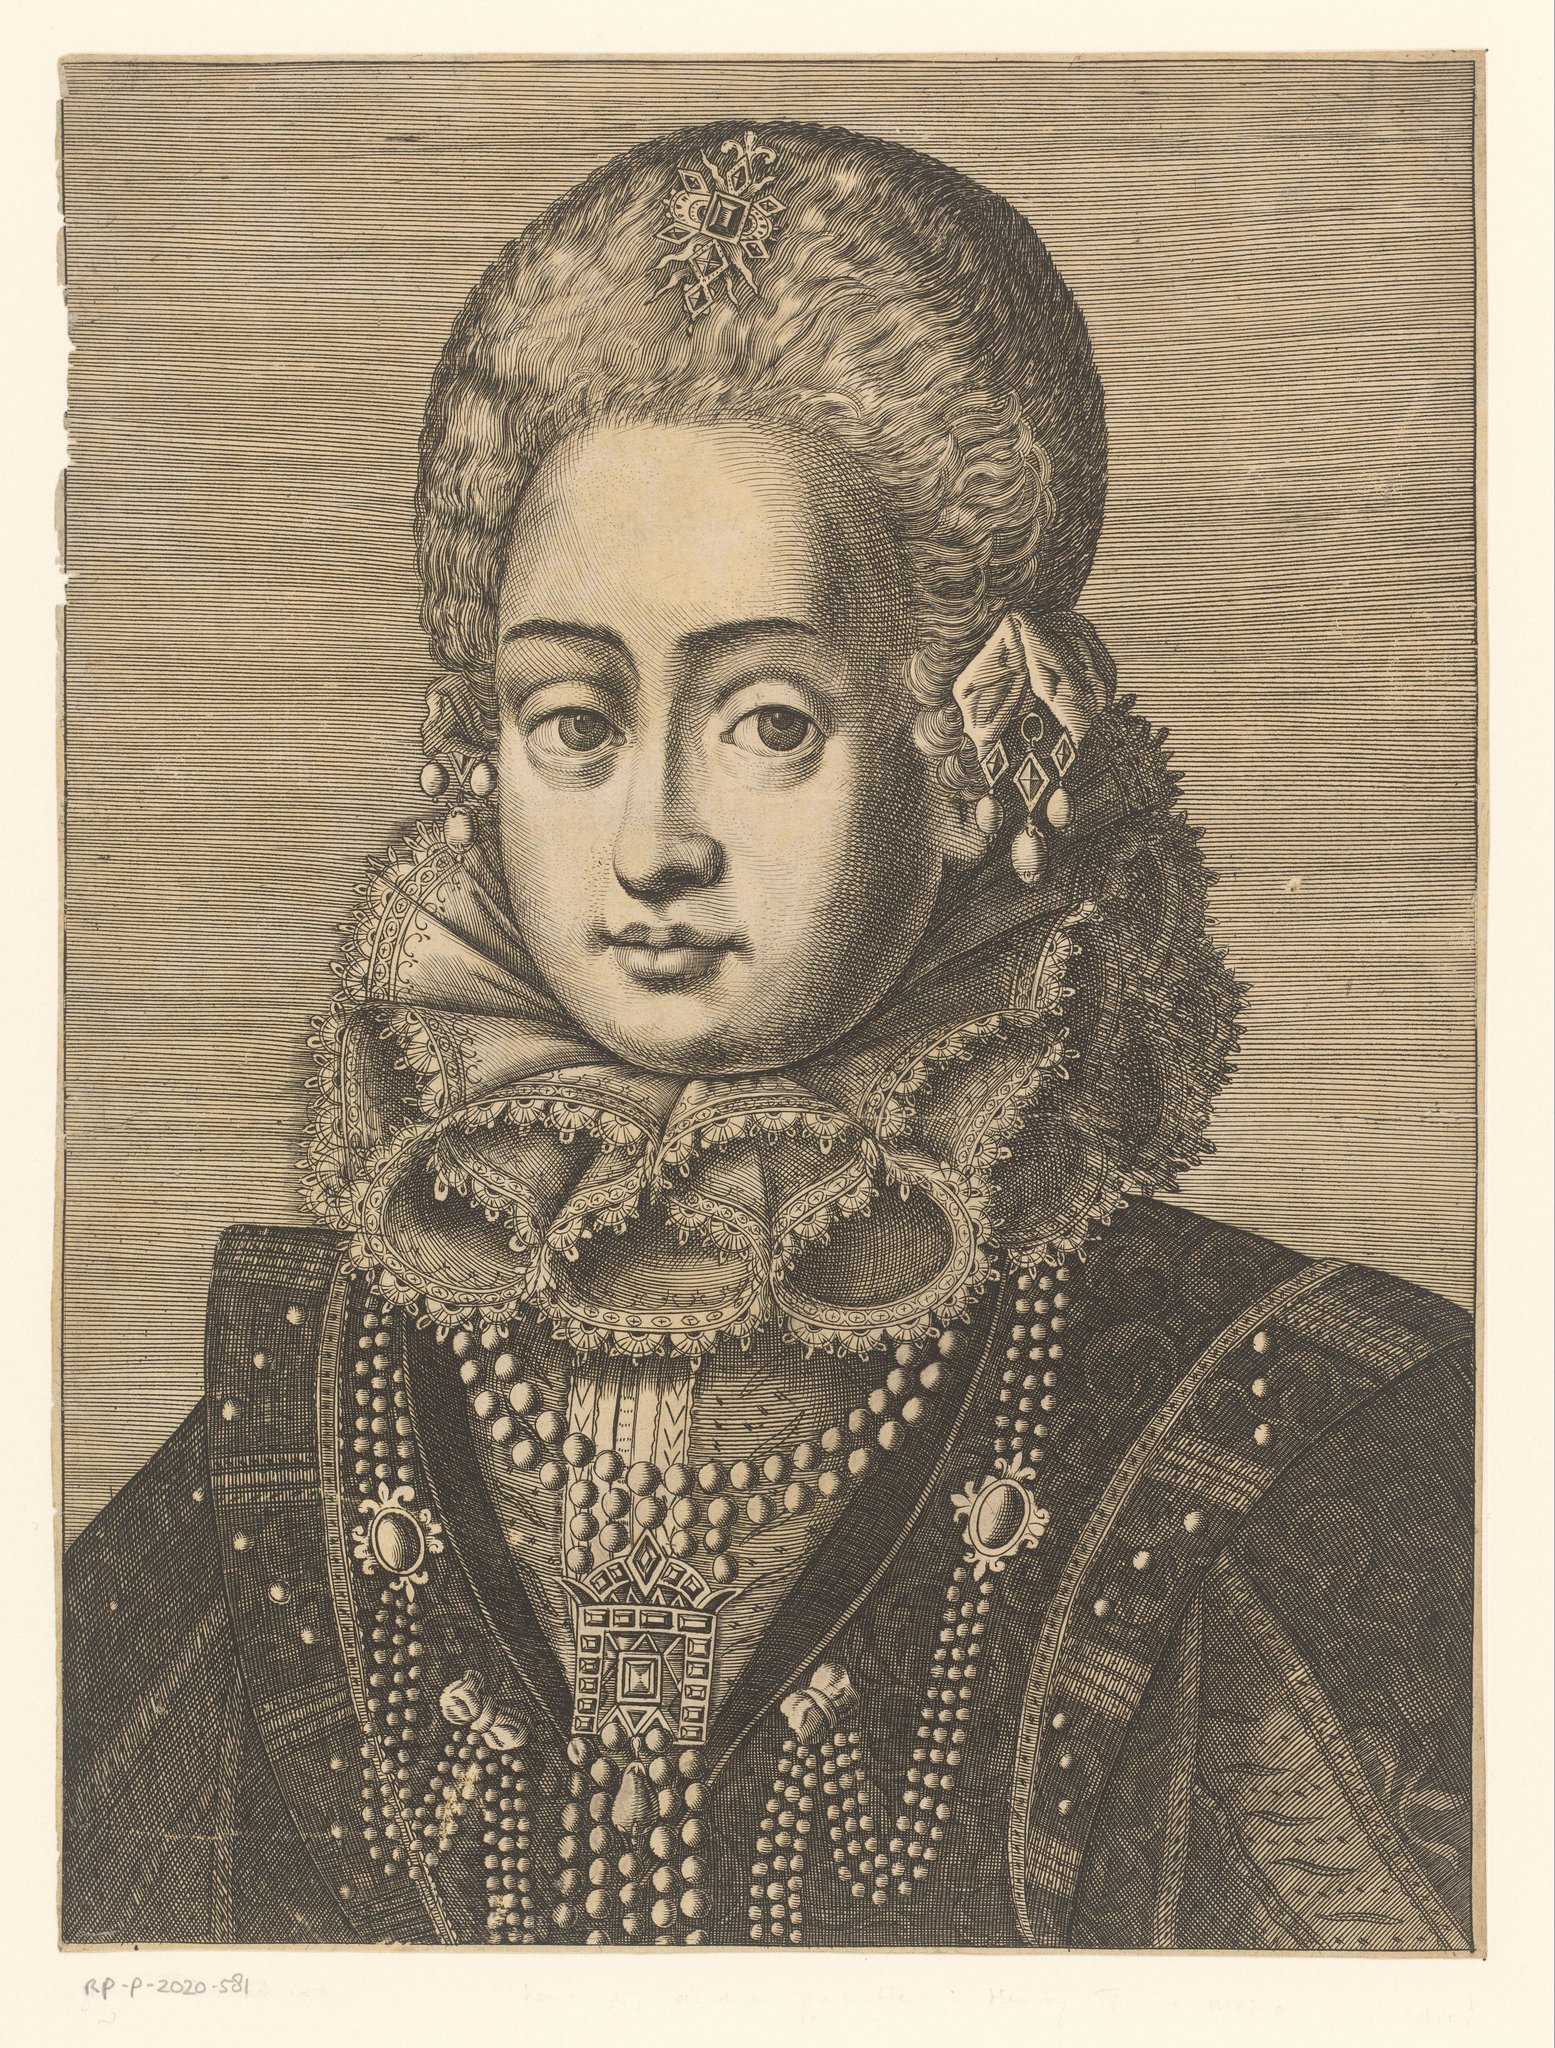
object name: print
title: Portret van Anna van Tirol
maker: johannes eillarts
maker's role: print maker, publisher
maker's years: 1568-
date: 1611-1630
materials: paper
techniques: engraving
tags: vienna, historical persons - bb - woman, neck-gear ~ clothing (with name) (+ women's clothes), pearl; pearl necklace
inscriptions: collector's mark: Lugt 2228, collector's mark: Lugt 2760